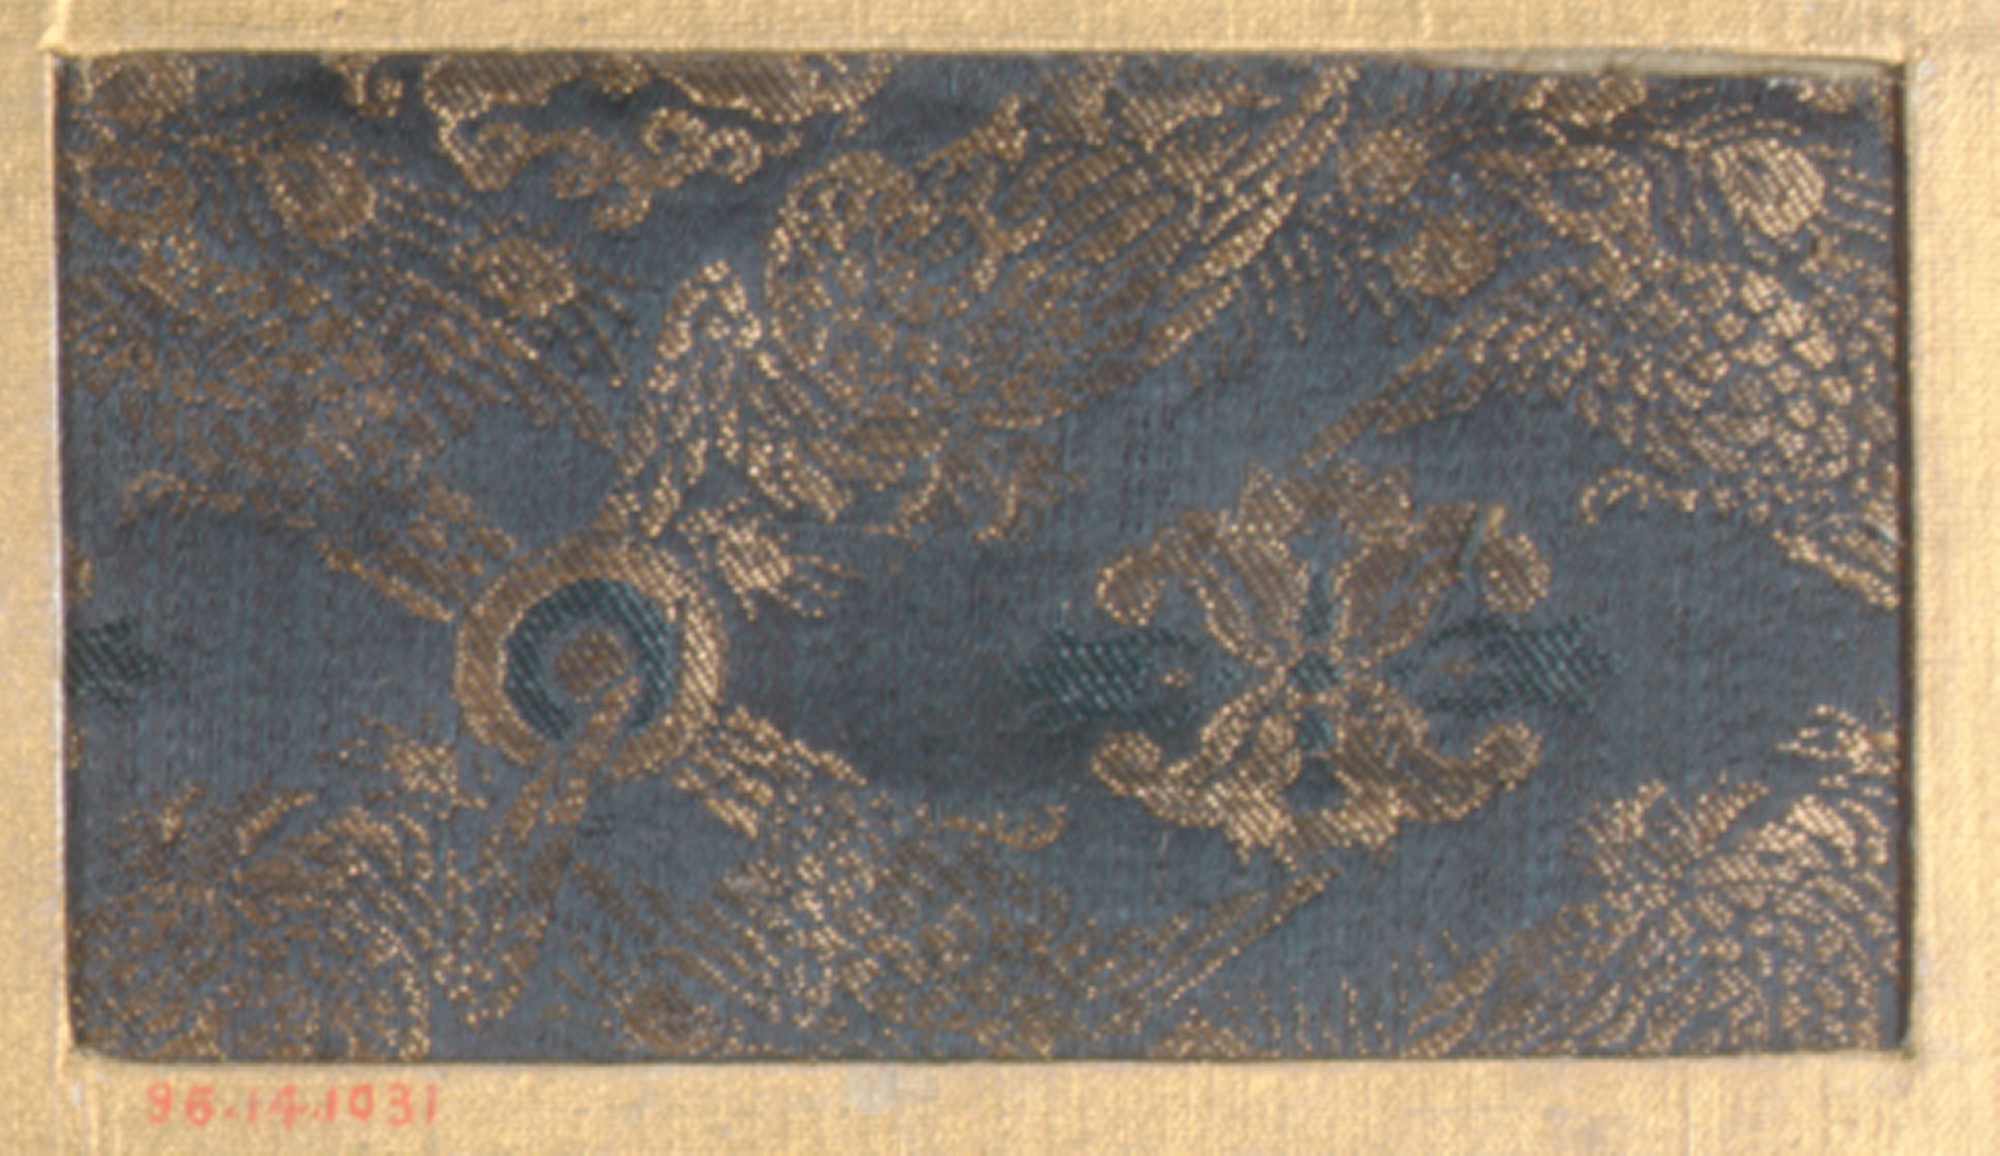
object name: piece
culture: japanese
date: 1701-1900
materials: silk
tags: birds